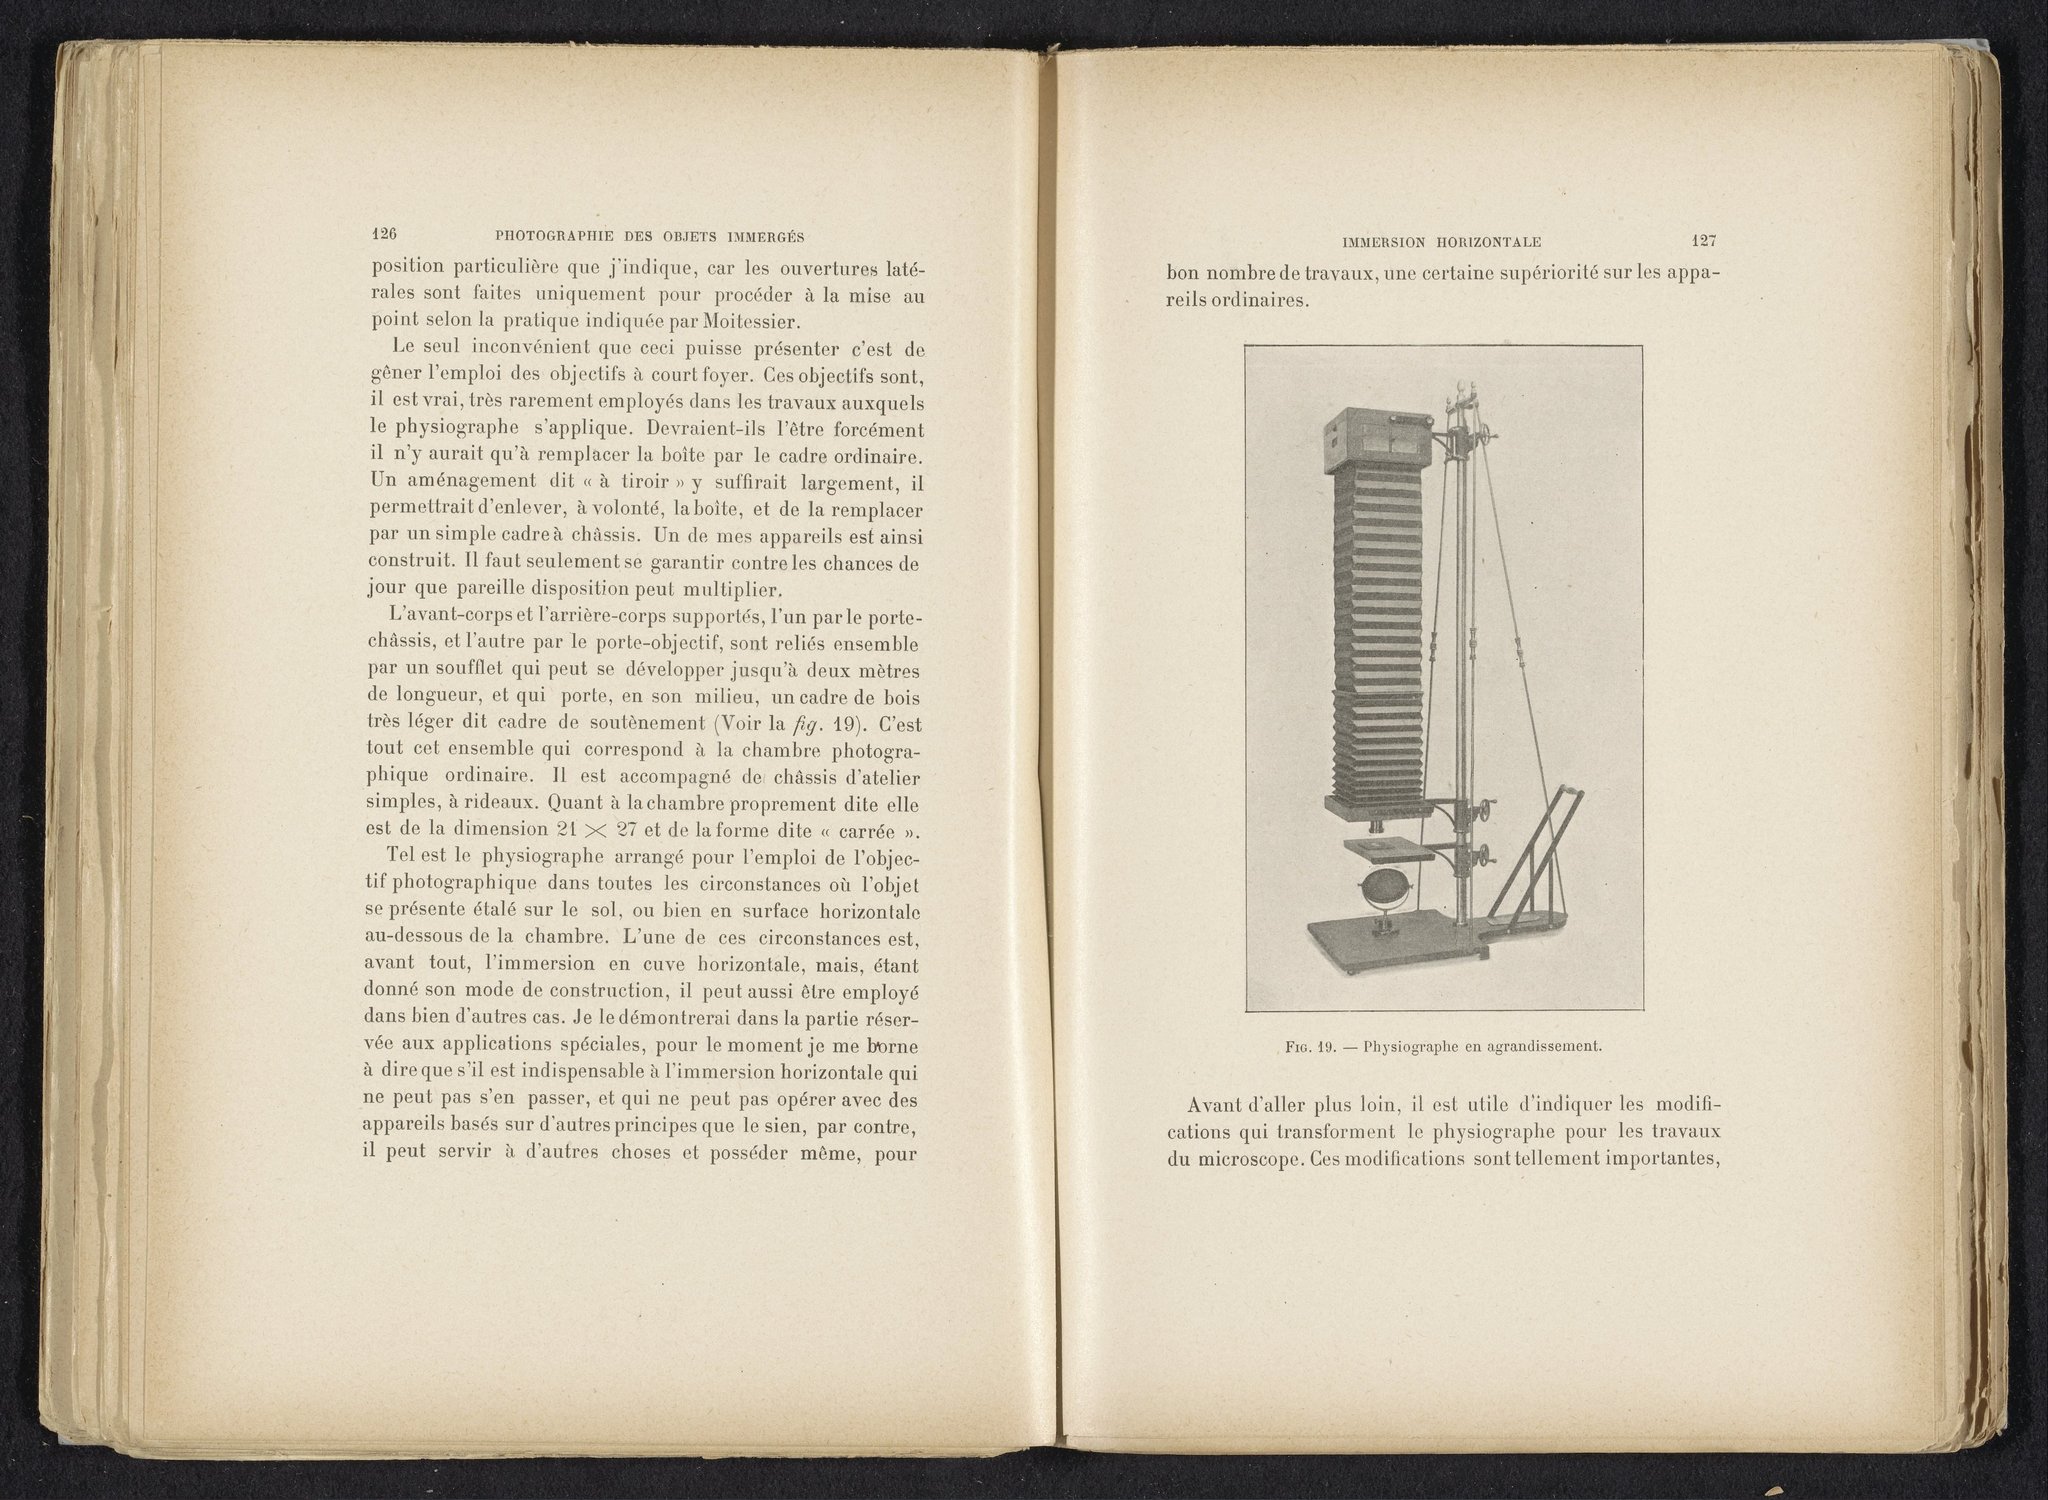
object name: page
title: Physiograaf die kan vergroten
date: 1891-1901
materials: paper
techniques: autotype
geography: paris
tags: drawing-instruments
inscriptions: number: ‘Fig. 19.’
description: Prent in album 'La photographie des objets immergés', 1901.